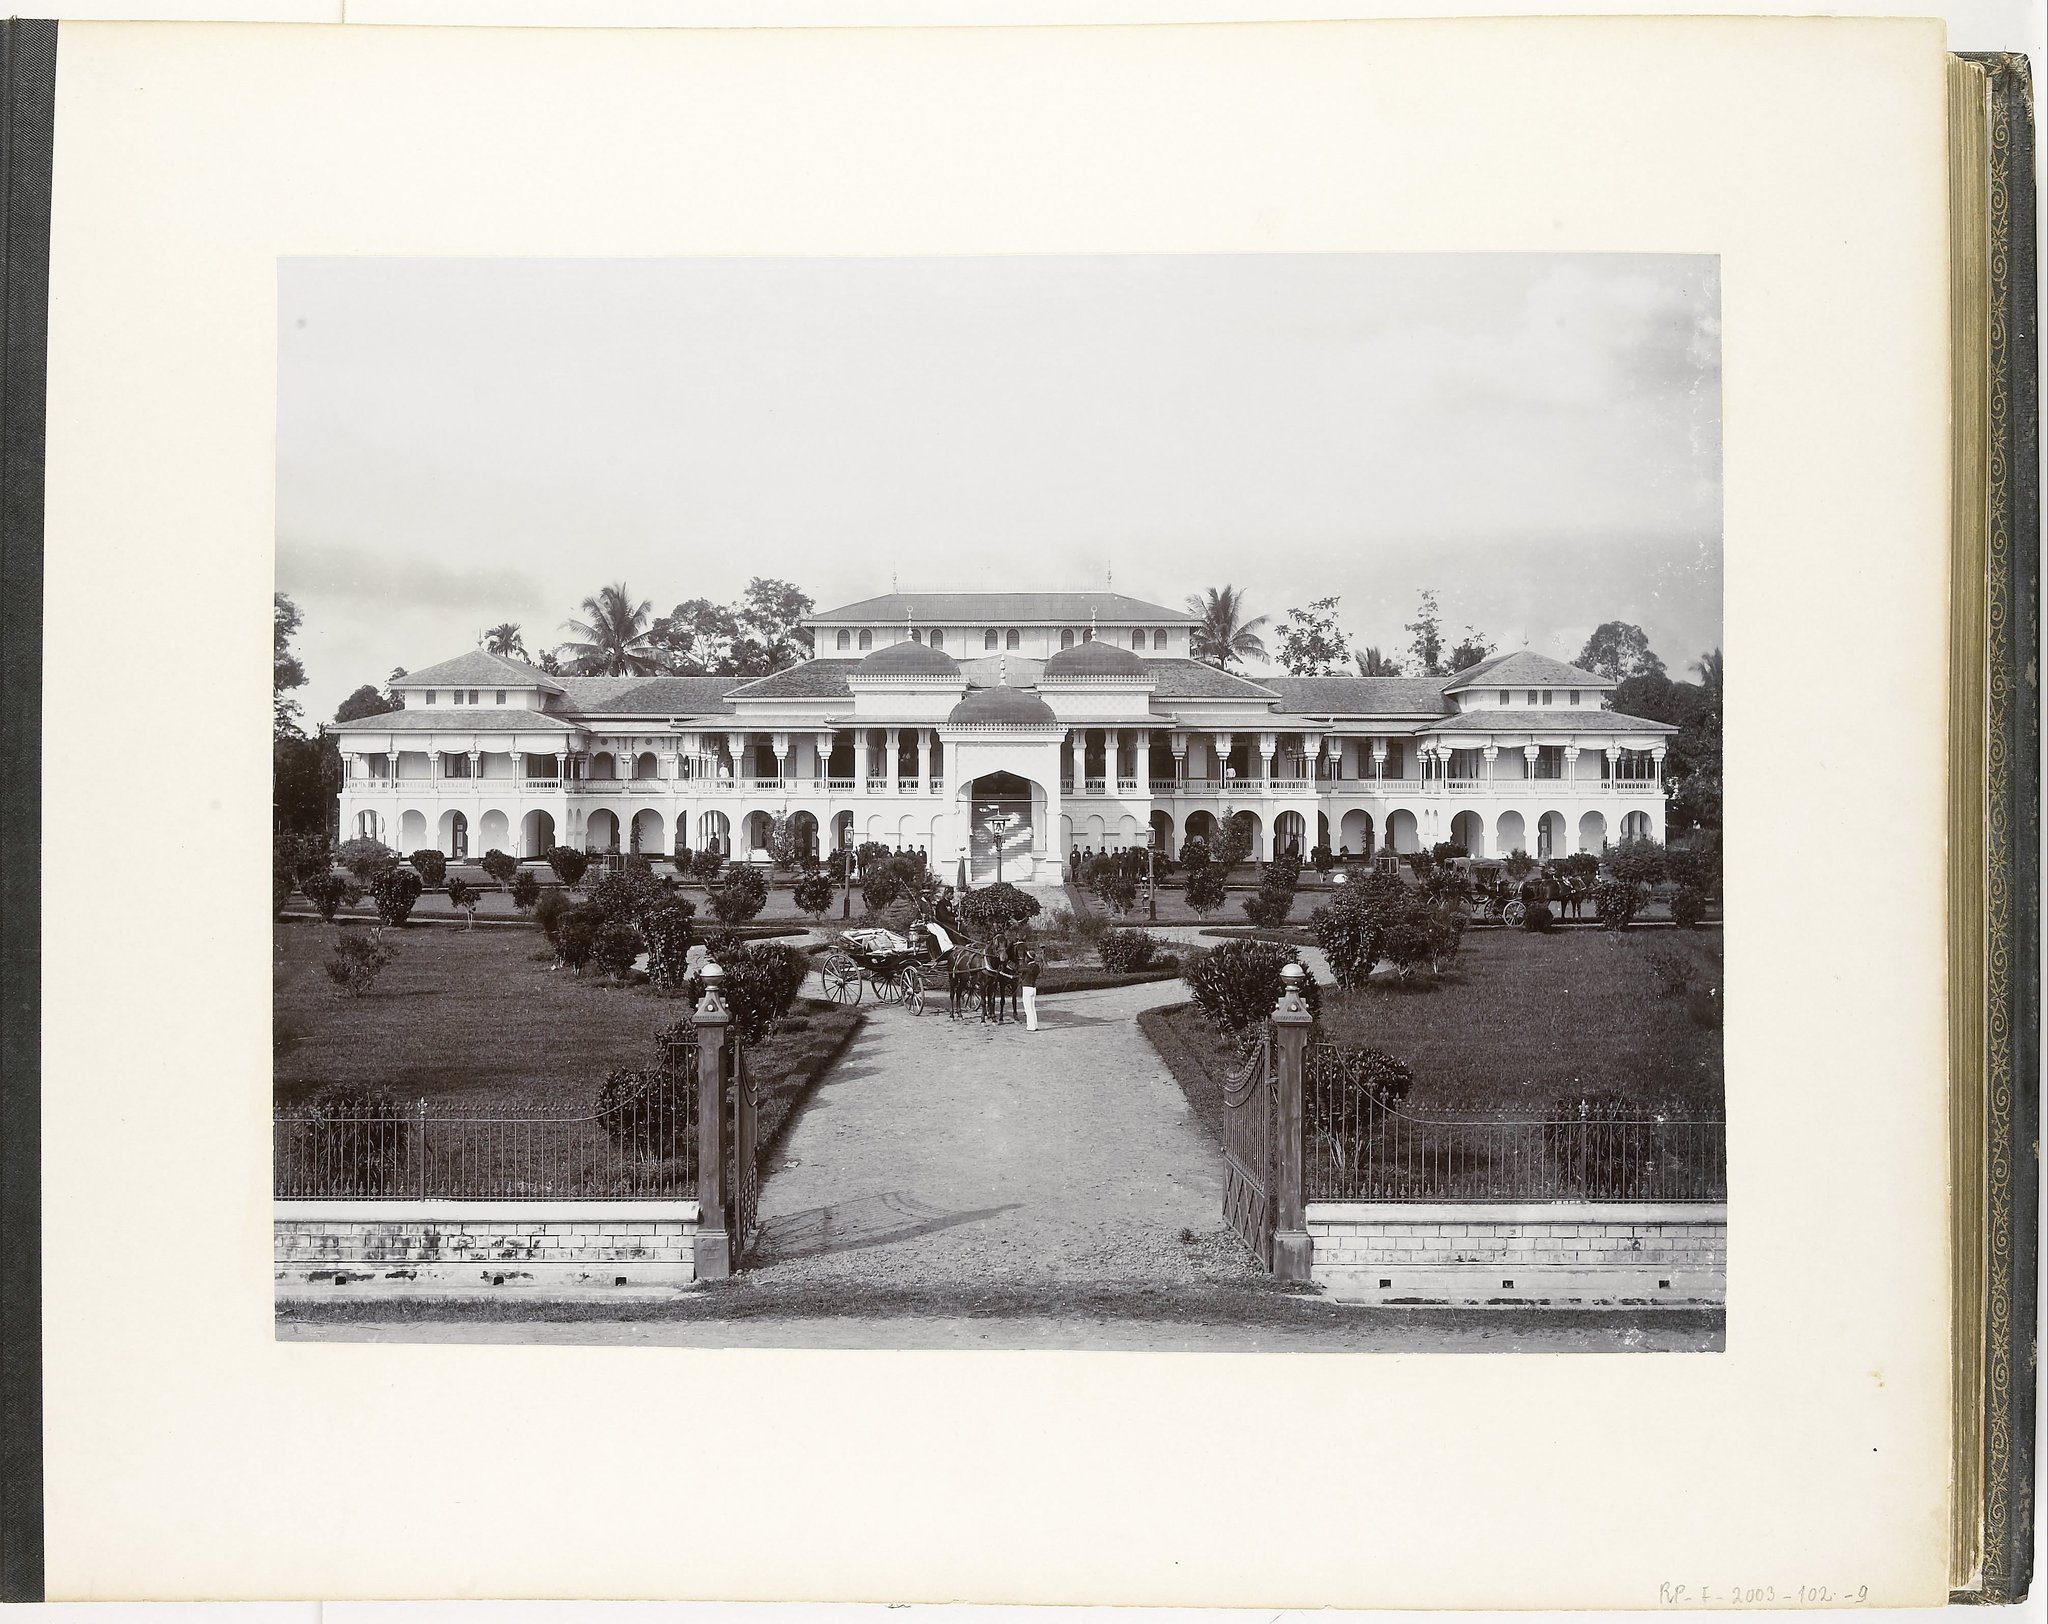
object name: photograph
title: Gezicht op het paleis van de Sultan van Deli, Sumatra (Palais des Sultans von Deli)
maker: carl j. kleingrothe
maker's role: fotograaf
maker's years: 1864-1925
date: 1885-1900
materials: photographic support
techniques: collodion silver print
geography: medan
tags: medan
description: Gezicht op het paleis van de sultan van Deli te Medan. Op de oprijlaan een rijtuig. Onderdeel van het Sumatra fotoalbum van Paul en Lucie Sandel uit 1900.